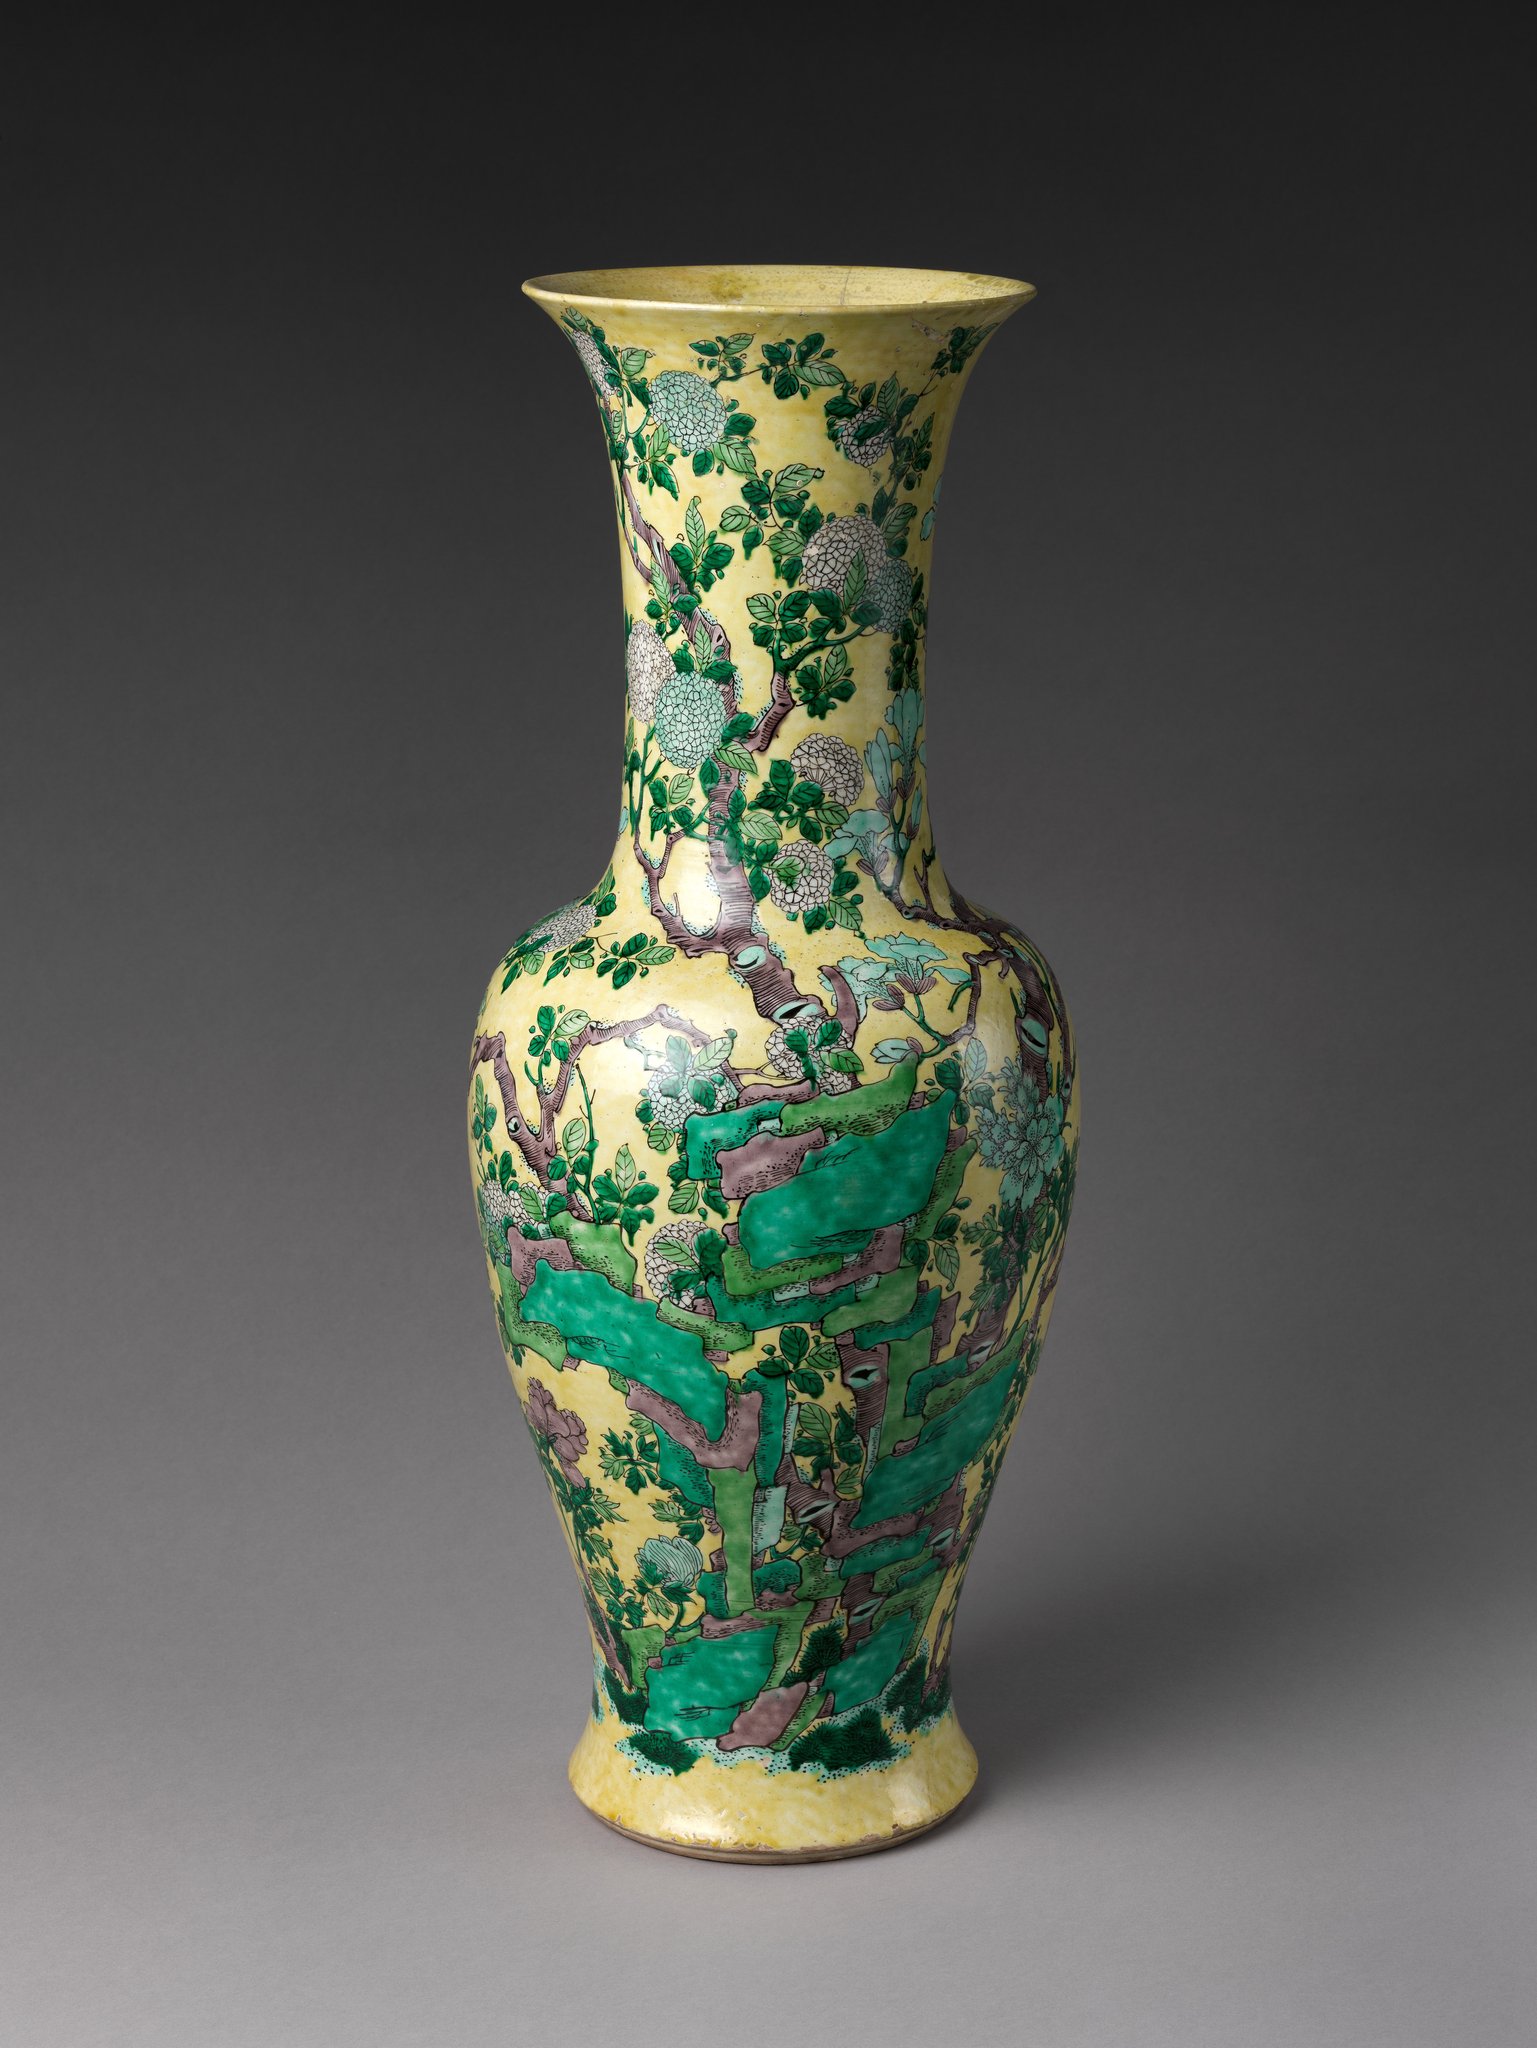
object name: vase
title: Vase with Rocks and Flowers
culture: chinese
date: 1801-1900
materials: biscuit, enamel, porcelain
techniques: painting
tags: flowers